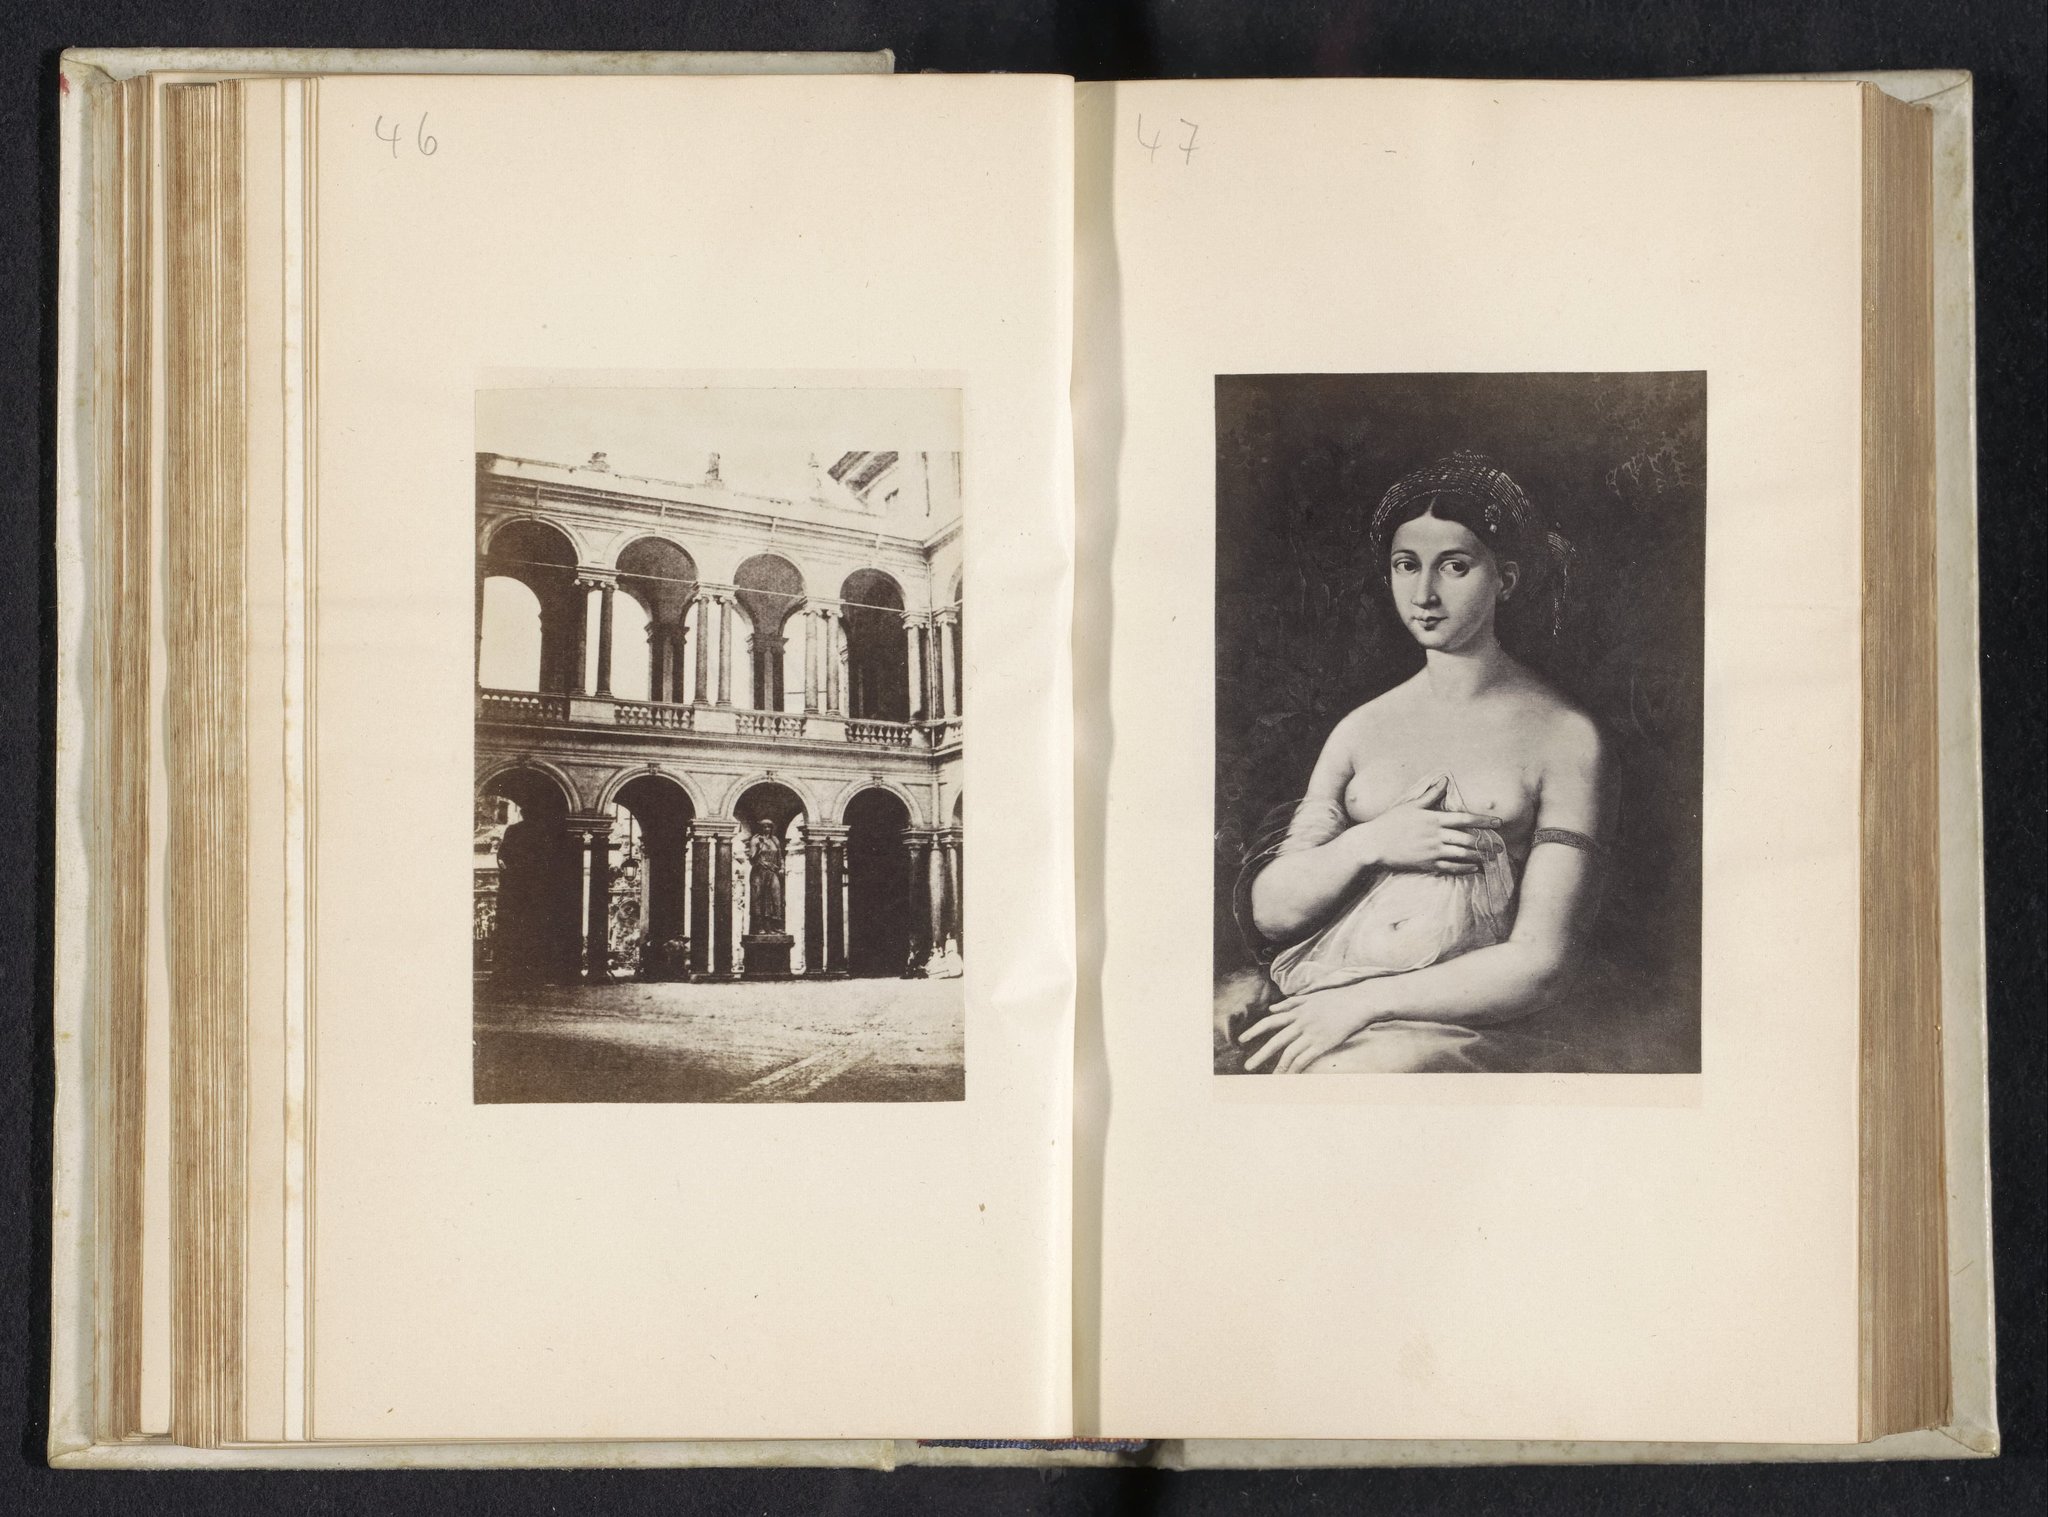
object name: photograph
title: Fotoreproductie van een schilderij, voorstellende een portret van een naakte vrouw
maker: Anonymous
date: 1850-1860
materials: photographic support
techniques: albumen print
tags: woman (showing herself) undressed, quasi-nude